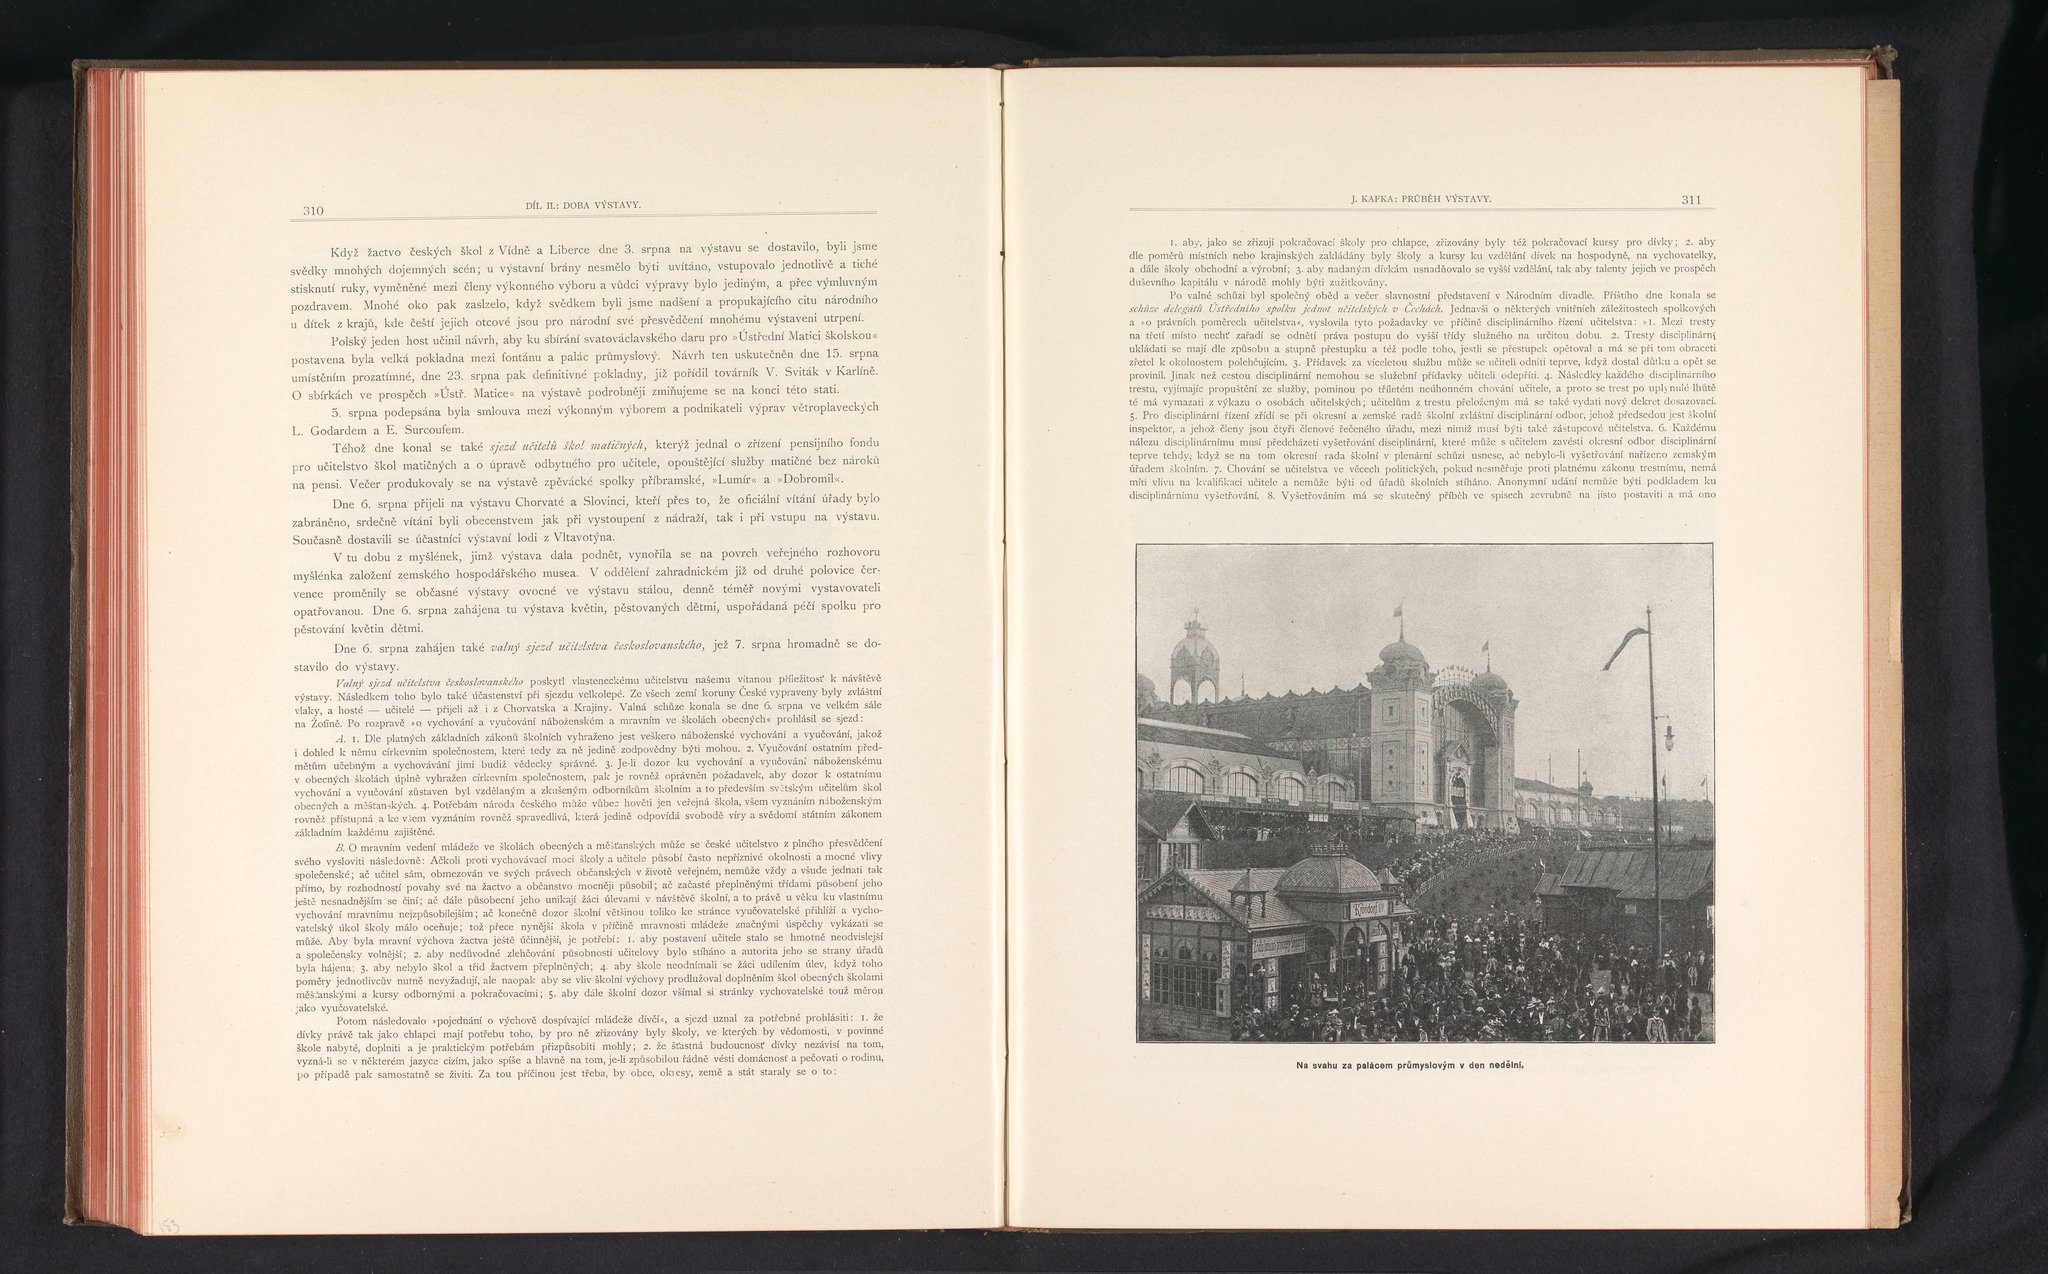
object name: photomechanical print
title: Gezicht op een menigte op het Výstaviště te Praag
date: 1891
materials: paper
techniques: autotype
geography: prague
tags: façade (of house or building), temporary exhibition, 'salon'